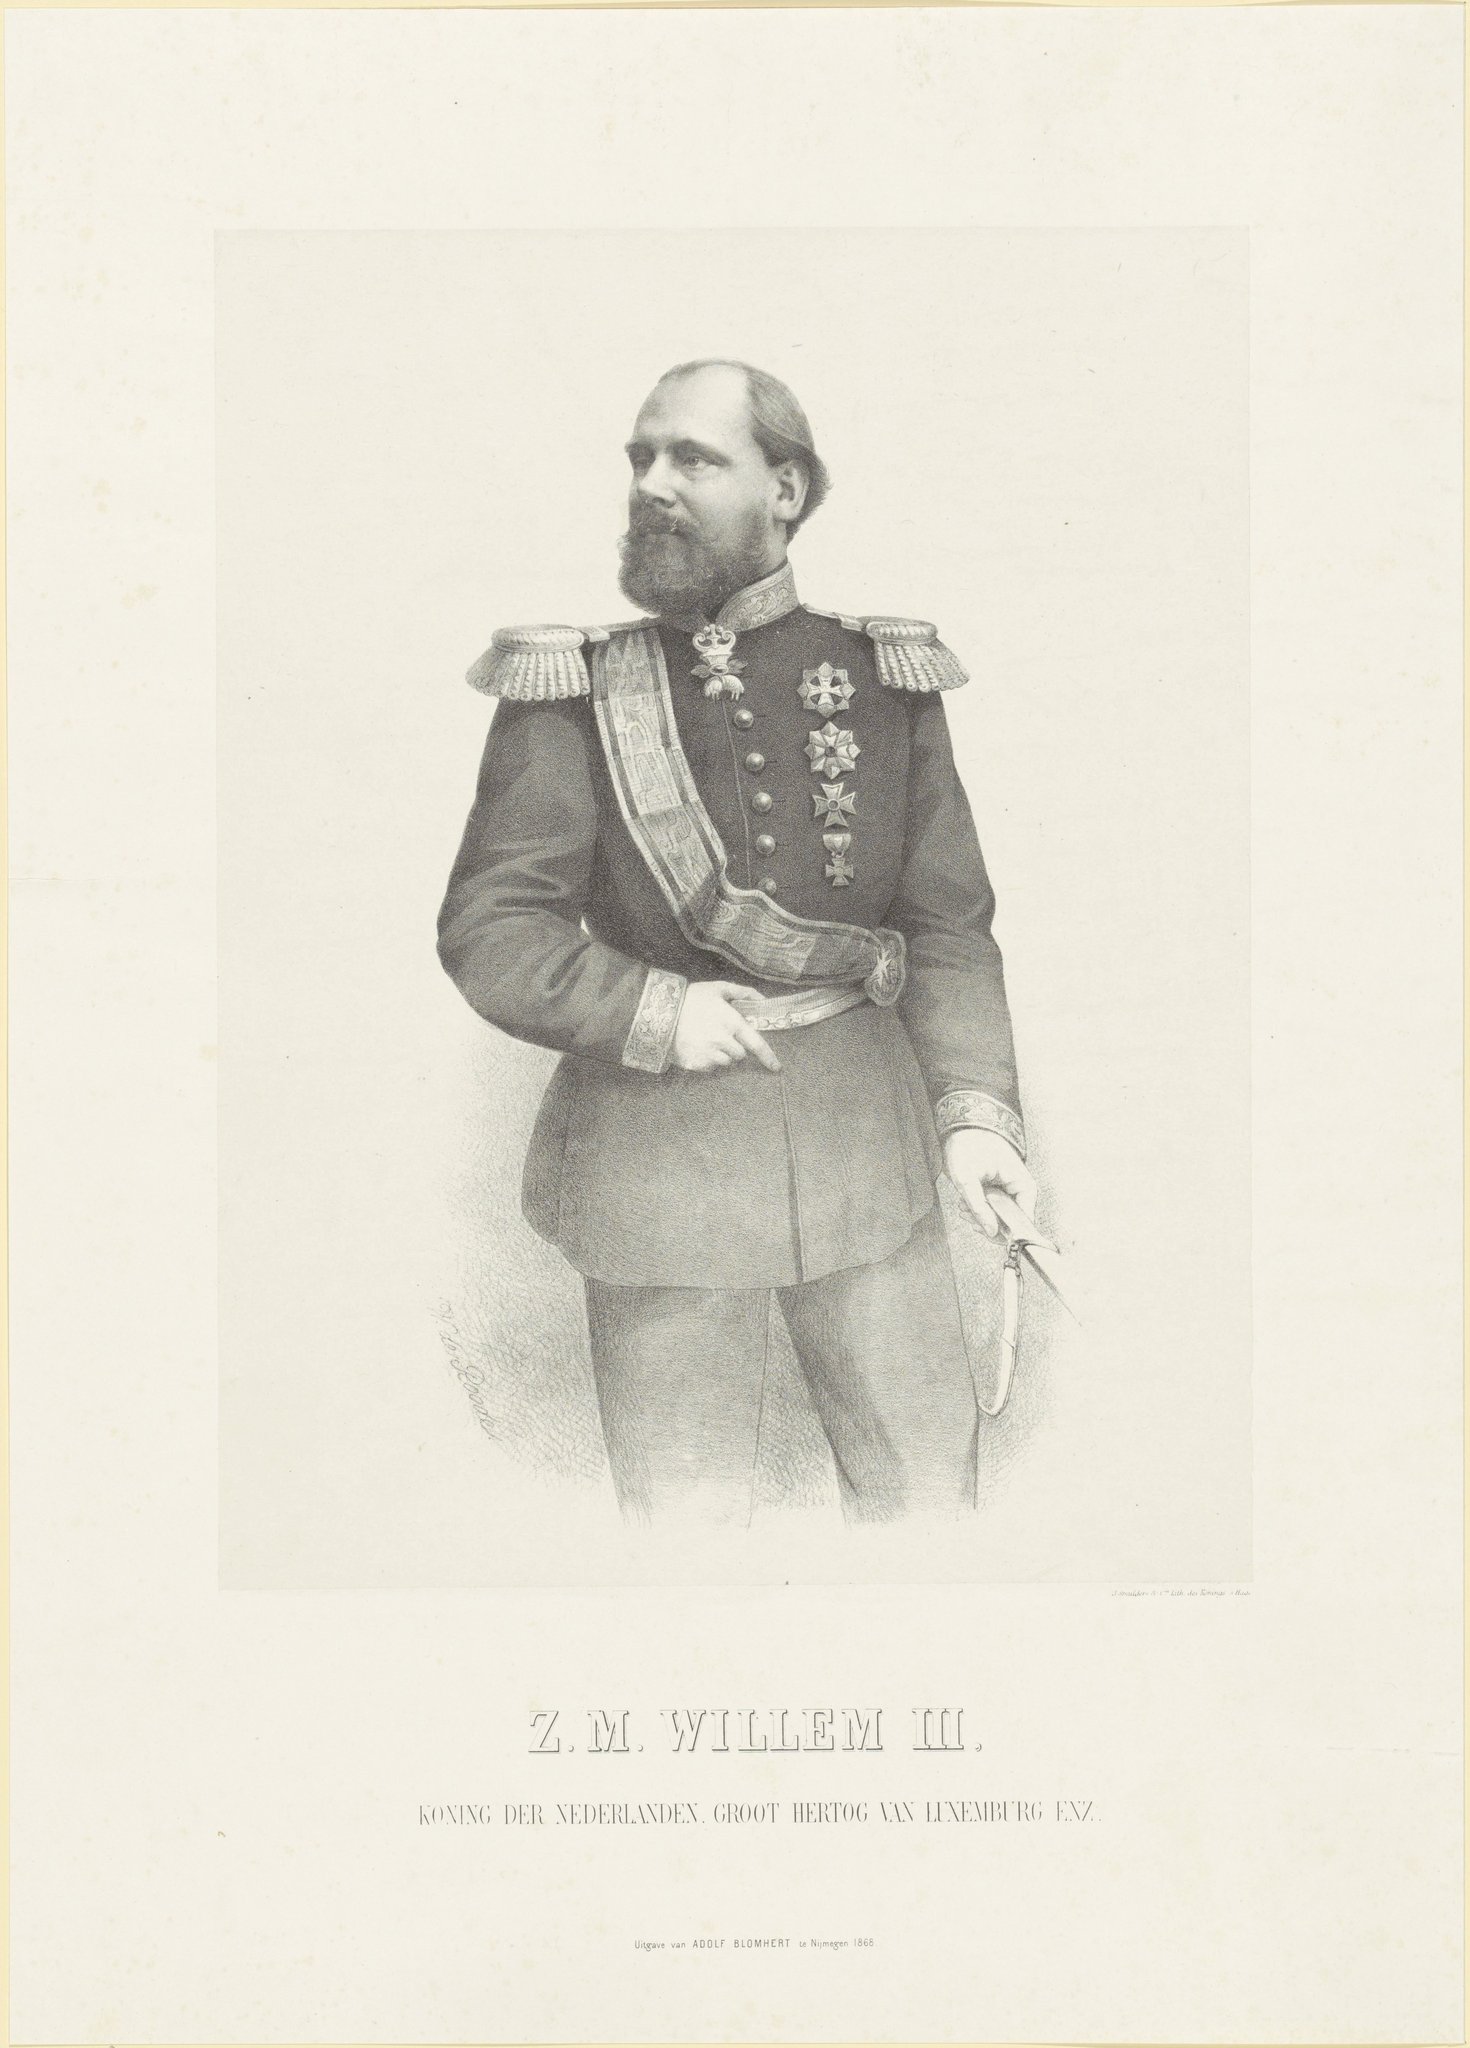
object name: print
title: Portret van Willem III, koning der Nederlanden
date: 1868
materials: paper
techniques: lithograph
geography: netherlands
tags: brussels, willem iii (koning der nederlanden), knighthood order of the golden fleece - insignia of a knighthood order, e.g.: badge, chain (with name of order)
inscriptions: date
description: De hier vermelde titel verwijst naar de hoogst verkregen titel van de geportretteerde, niet per se naar de titel die de geportretteerde op deze voorstelling draagt.